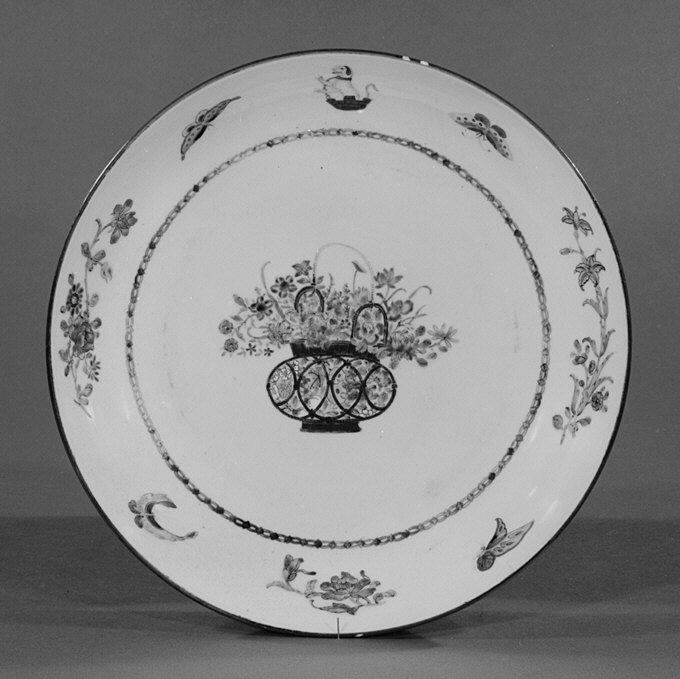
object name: plate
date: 1755-1760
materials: hard paste porcelain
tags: butterflies,flowers